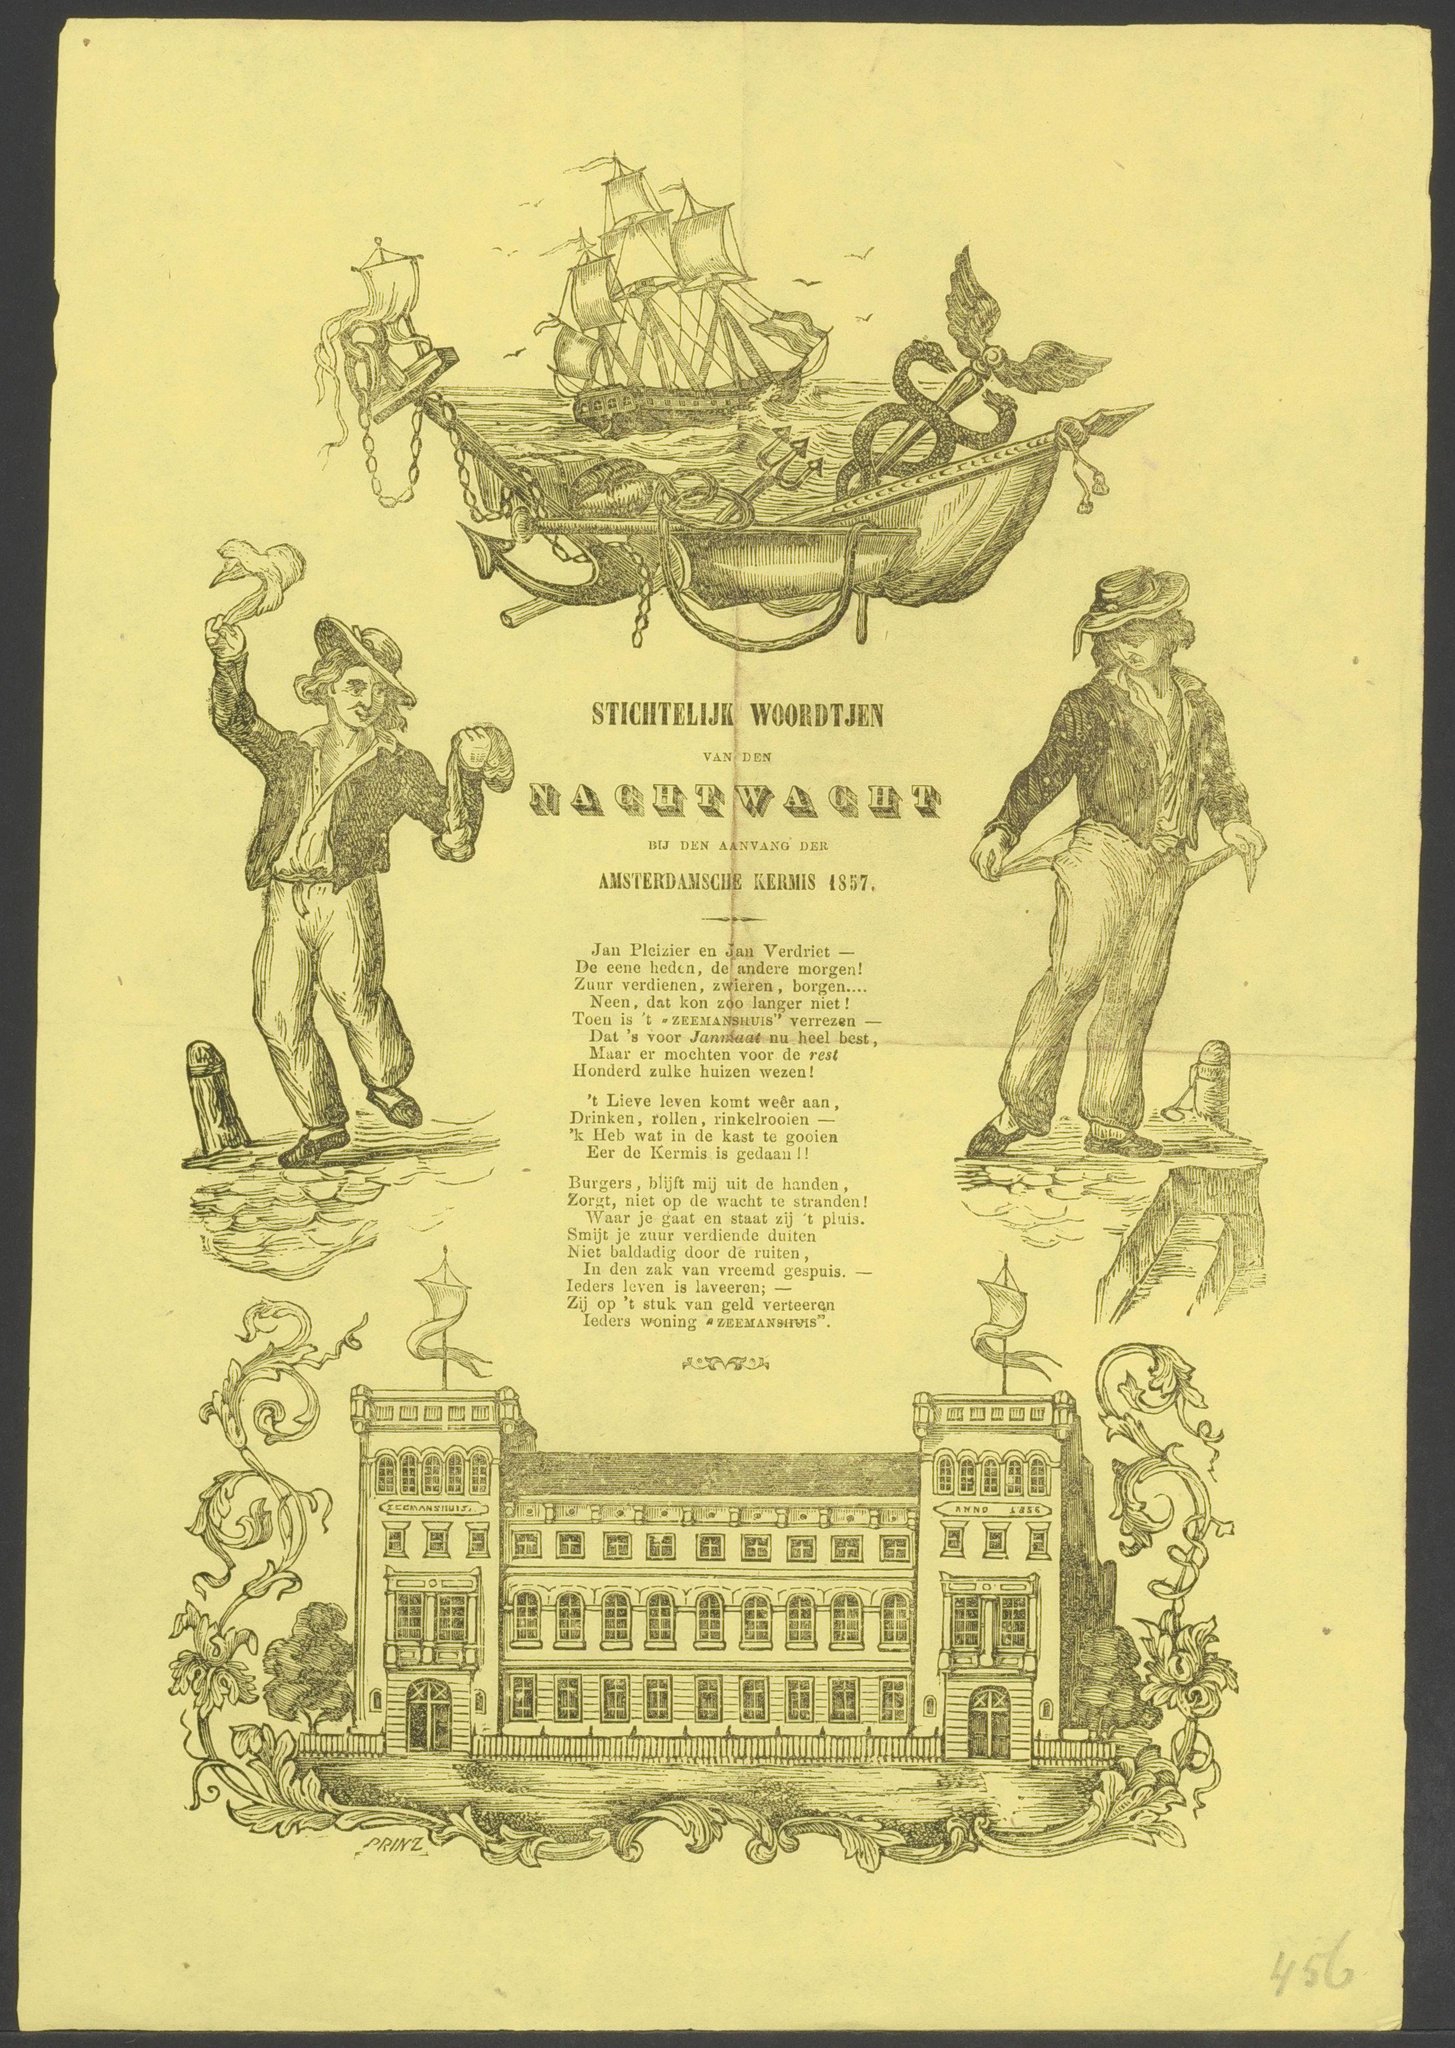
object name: fair print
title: Stichtelijk woordtjen van den Nachtwacht bij den aanvang der Amsterdamsche kermis 1857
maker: friedrich robert prinz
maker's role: print maker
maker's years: 1820-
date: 1857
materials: paper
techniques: letterpress printing, engraving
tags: night patrol, sailing-ship, sailing-boat, seaman: sailor, amsterdam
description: Kermisprent van de Amsterdamse nachtwacht, september 1857. Centraal een gedicht, bovenaan een schip op zee en onderaan het Zeemanshuis. Links en rechts van het gedichttwee zeemannen, een is platzak. Onderwerpsrubrieken binnen de Atlas Zeden en Gewoonten: Zeden en gewoonten in engeren zin, Volksleven, Volksbladen, Nieuwjaars- en Kerstwenschen, Amsterdam.